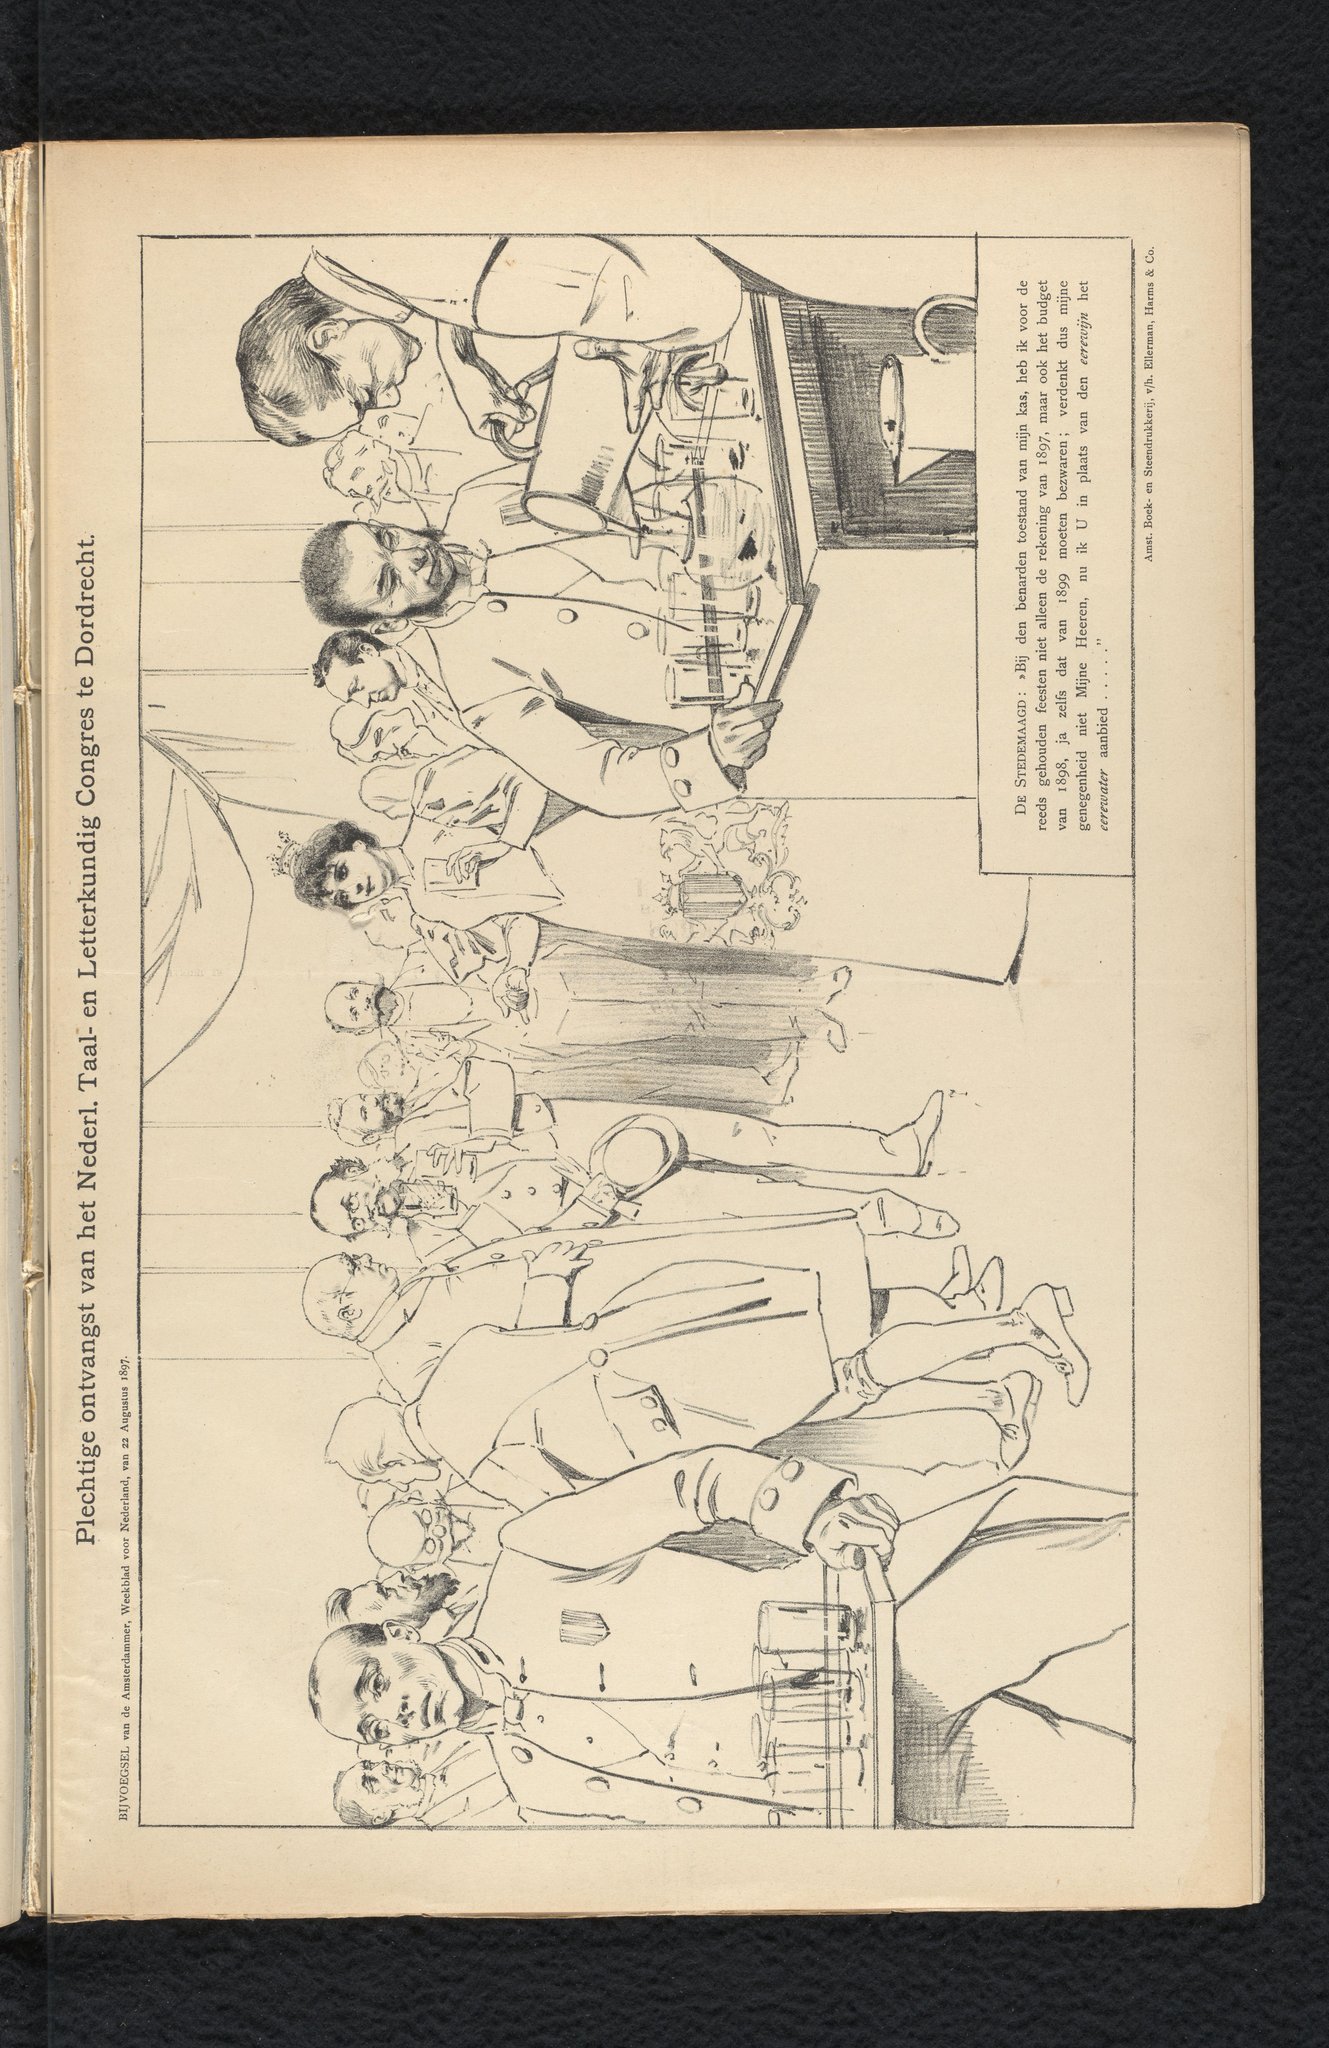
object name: cartoon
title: Plechtige ontvangst van het Nederl. Taal- en Letterkundig Congres te Dordrecht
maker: johan braakensiek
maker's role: draughtsman, print maker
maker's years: 1858-1940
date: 1897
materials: paper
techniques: lithograph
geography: amsterdam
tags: personification of a city, town-patron(ess), reception, cocktail party, political caricatures and satires, dordrecht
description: De stedenmaagd van Dordrecht kondigt bezuinigingen aan op het Nederlandsch Taal- en Letterkundig Congres van 1897. Er wordt water in plaats van wijn geschonken.